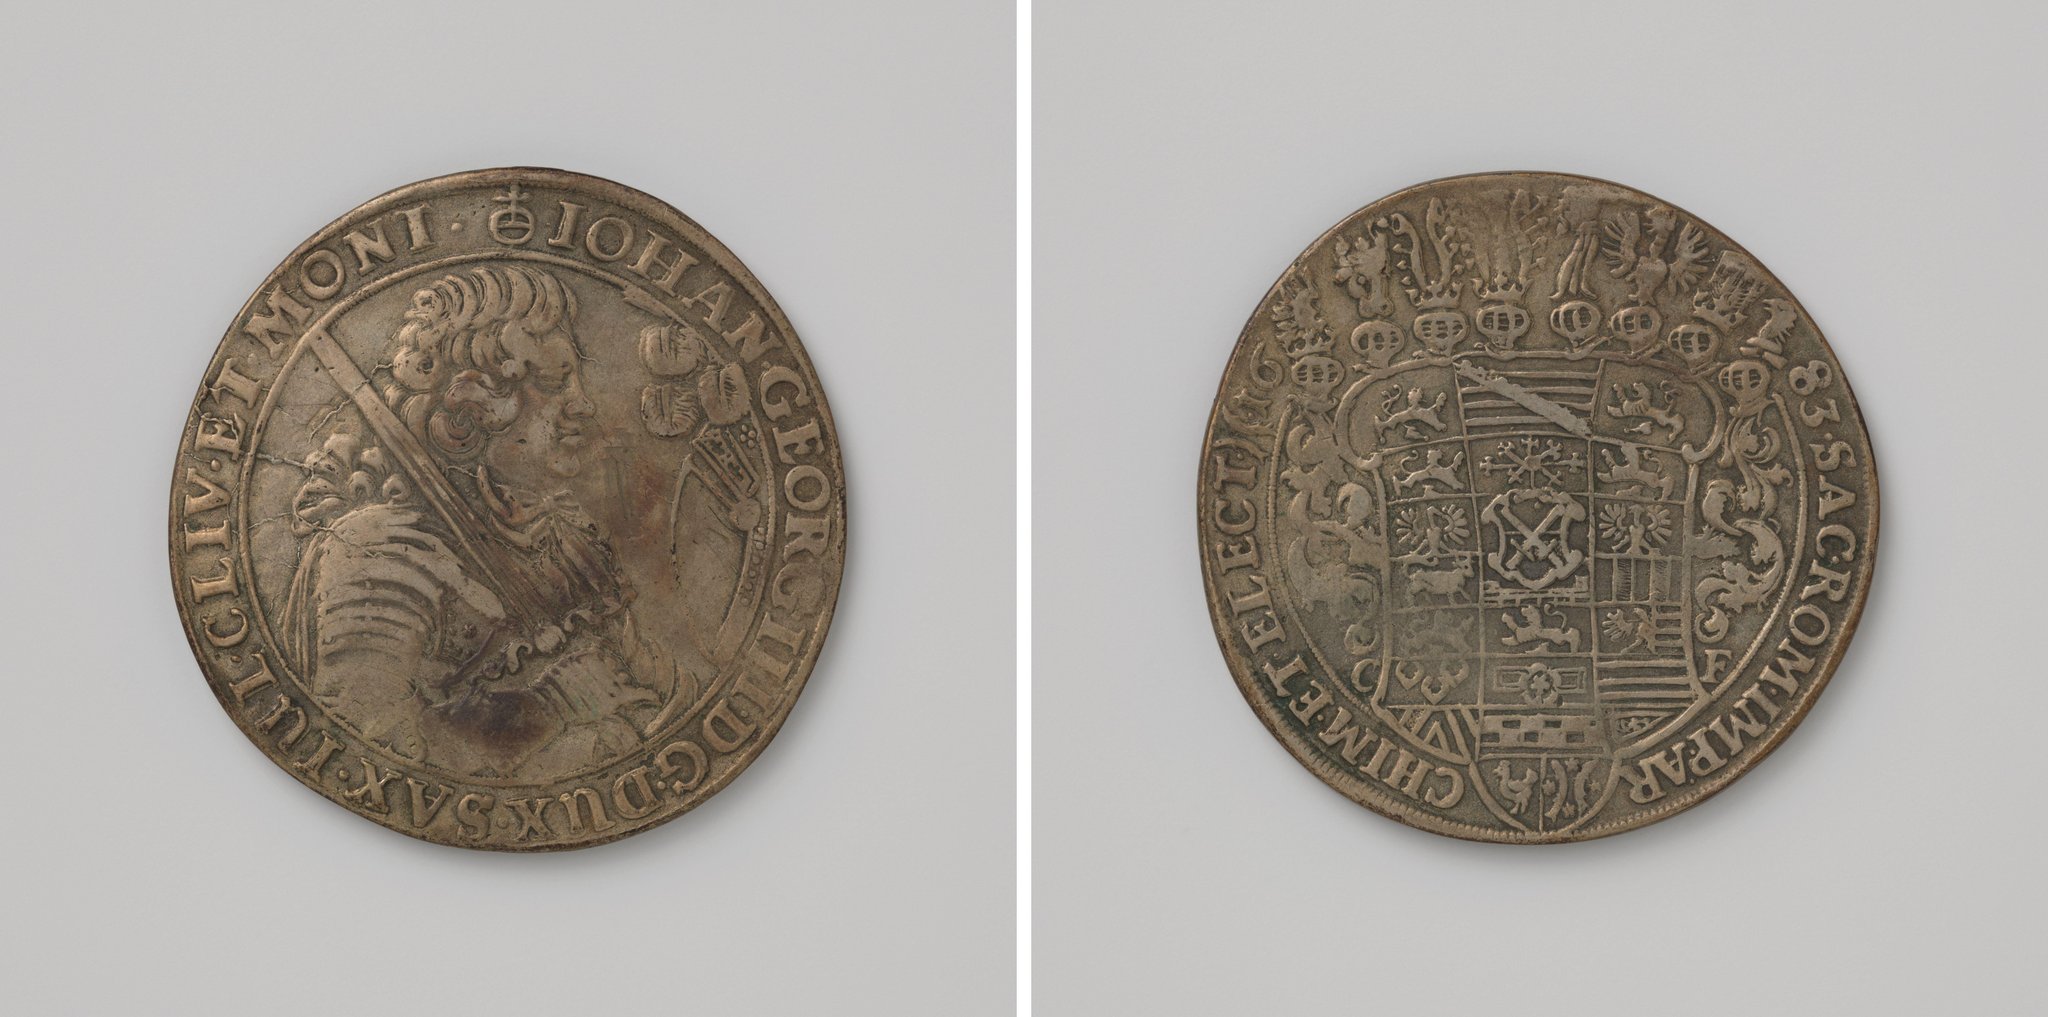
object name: taler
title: Taler van Johan Georg III, keurvorst van Saksen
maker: christoph fischer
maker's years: 1620-1686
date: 1683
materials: silver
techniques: gilding, striking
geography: dresden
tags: tübingen, keurvorst, keurvorst van saksen johan georg iii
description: Voorzijde: portret man naar rechts met zwaard over rechter schouder en voor zich helm [?] binnen omschrift. Keerzijde: wapenschild bedekt door acht helmen binnen omschrift